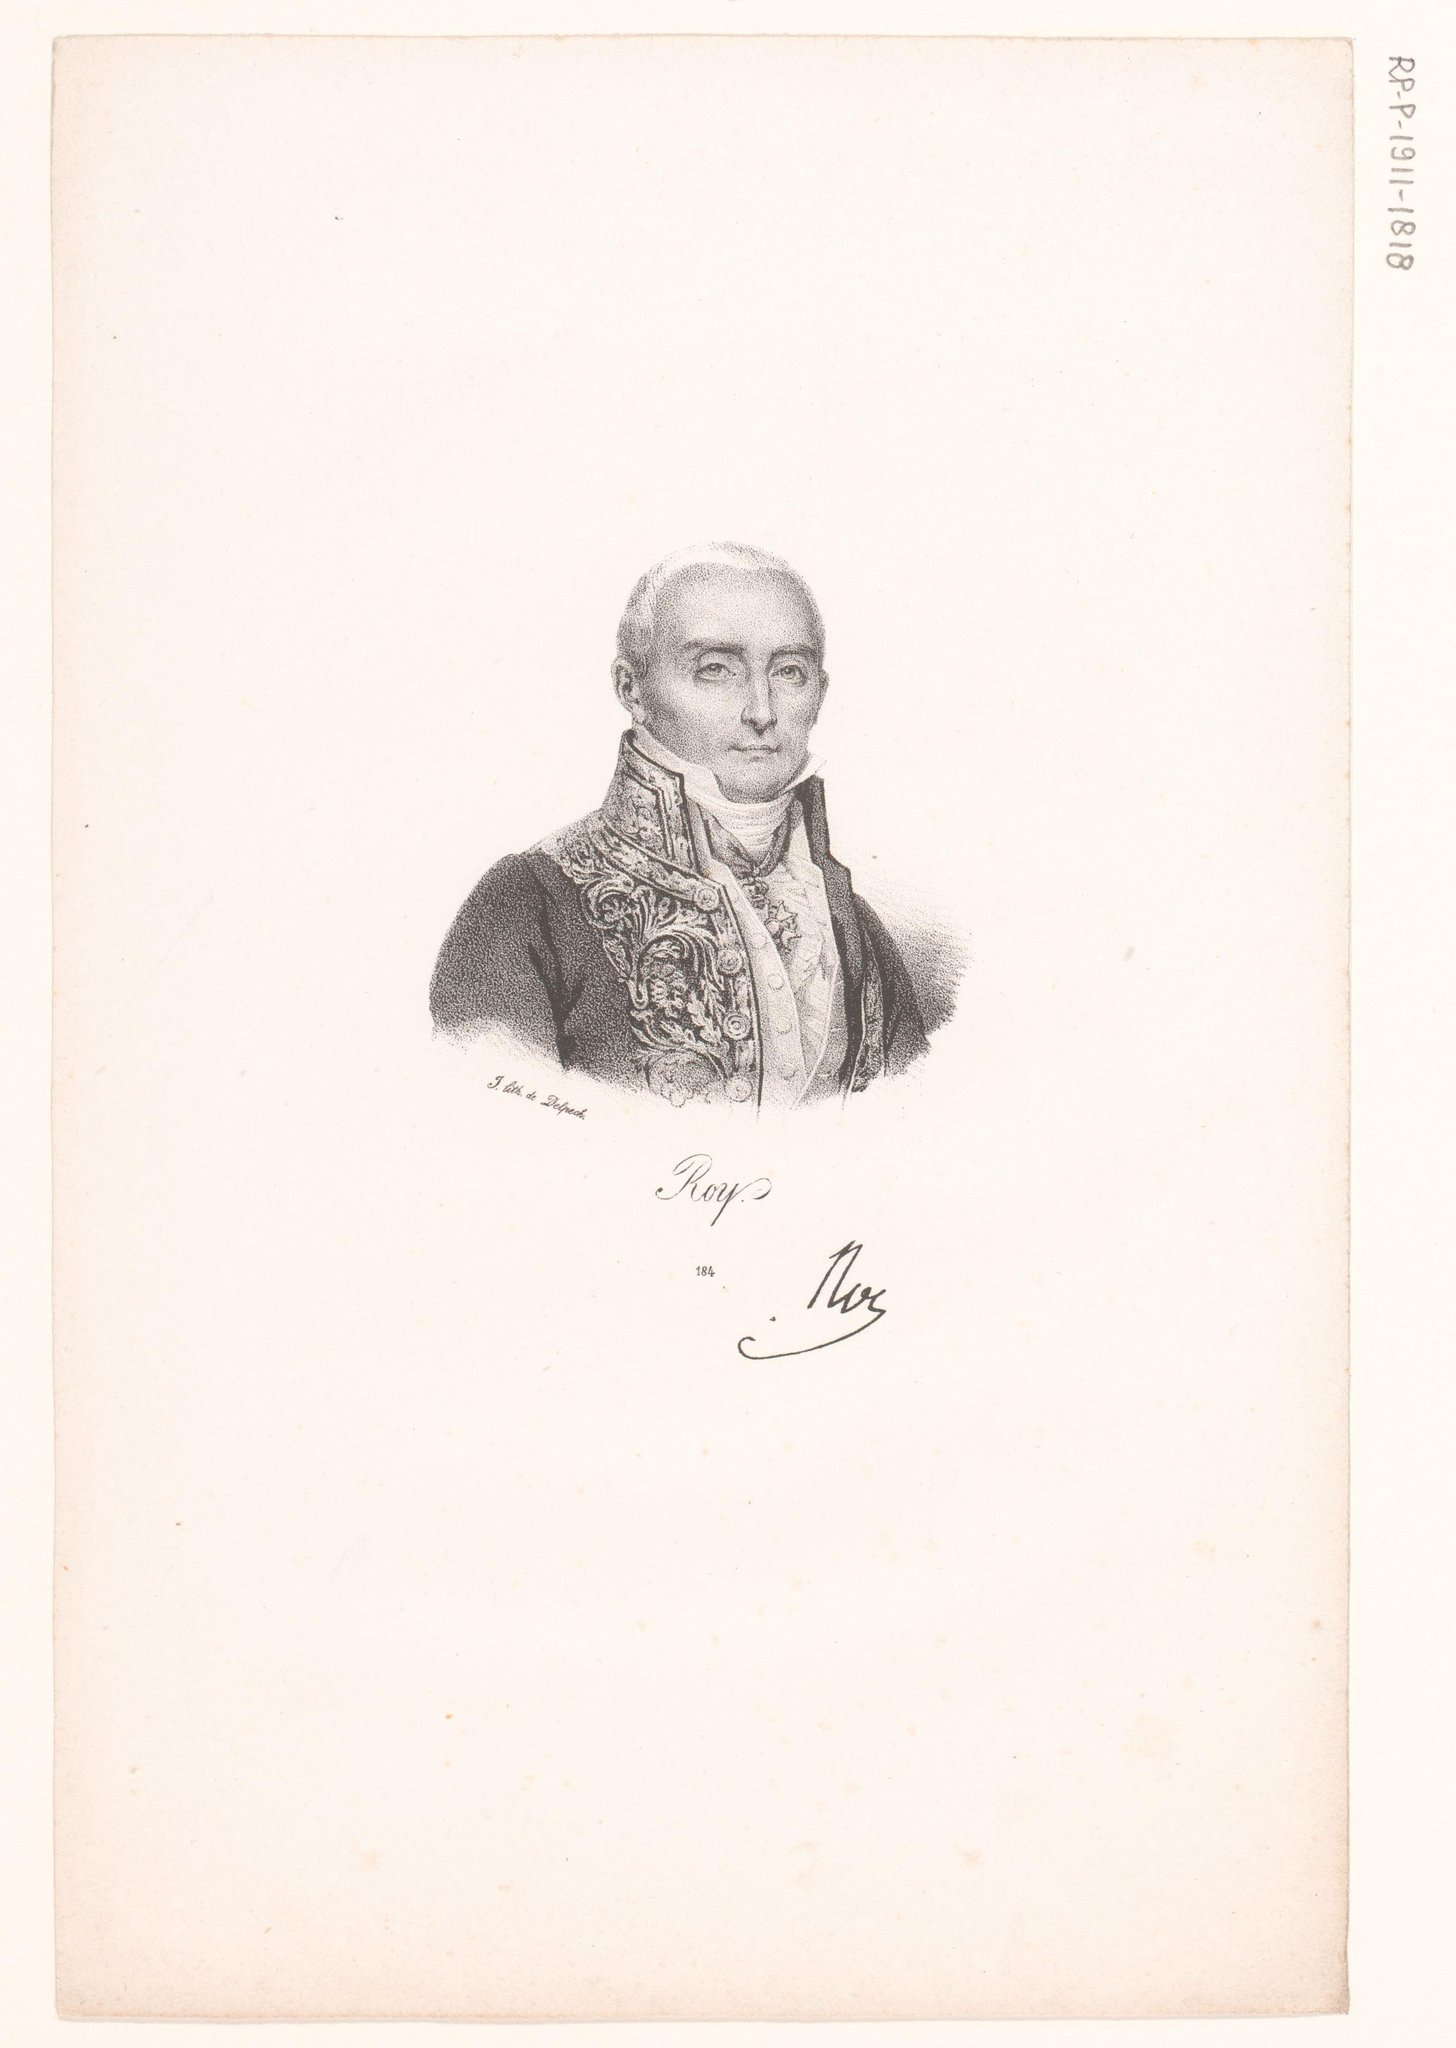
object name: print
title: Roy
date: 1830-1842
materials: paper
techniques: lithograph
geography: paris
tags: historical persons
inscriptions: collector's mark: Lugt 2228a